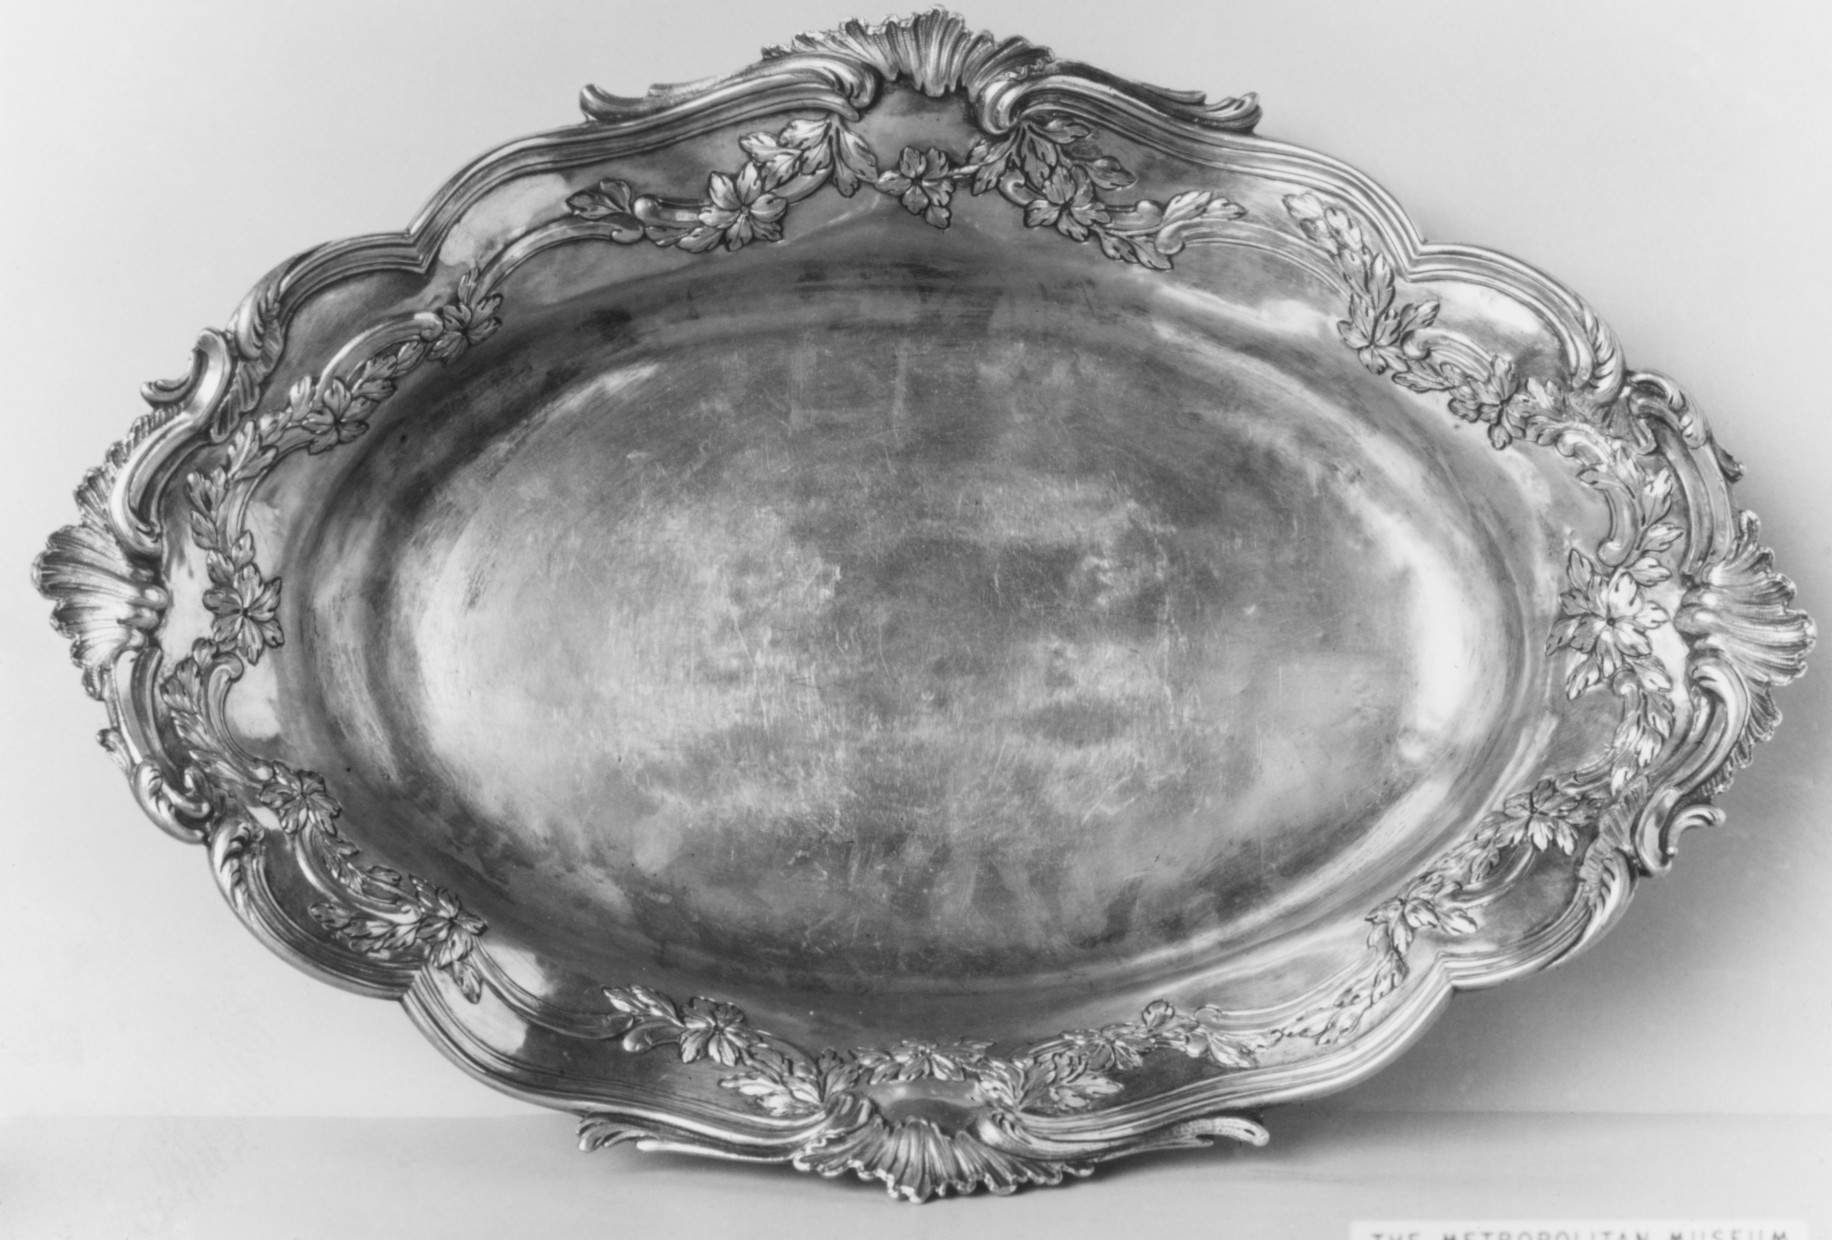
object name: basin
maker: barthélemy samson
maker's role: maker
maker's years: 1682-1782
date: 1771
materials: silver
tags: flowers,leaves